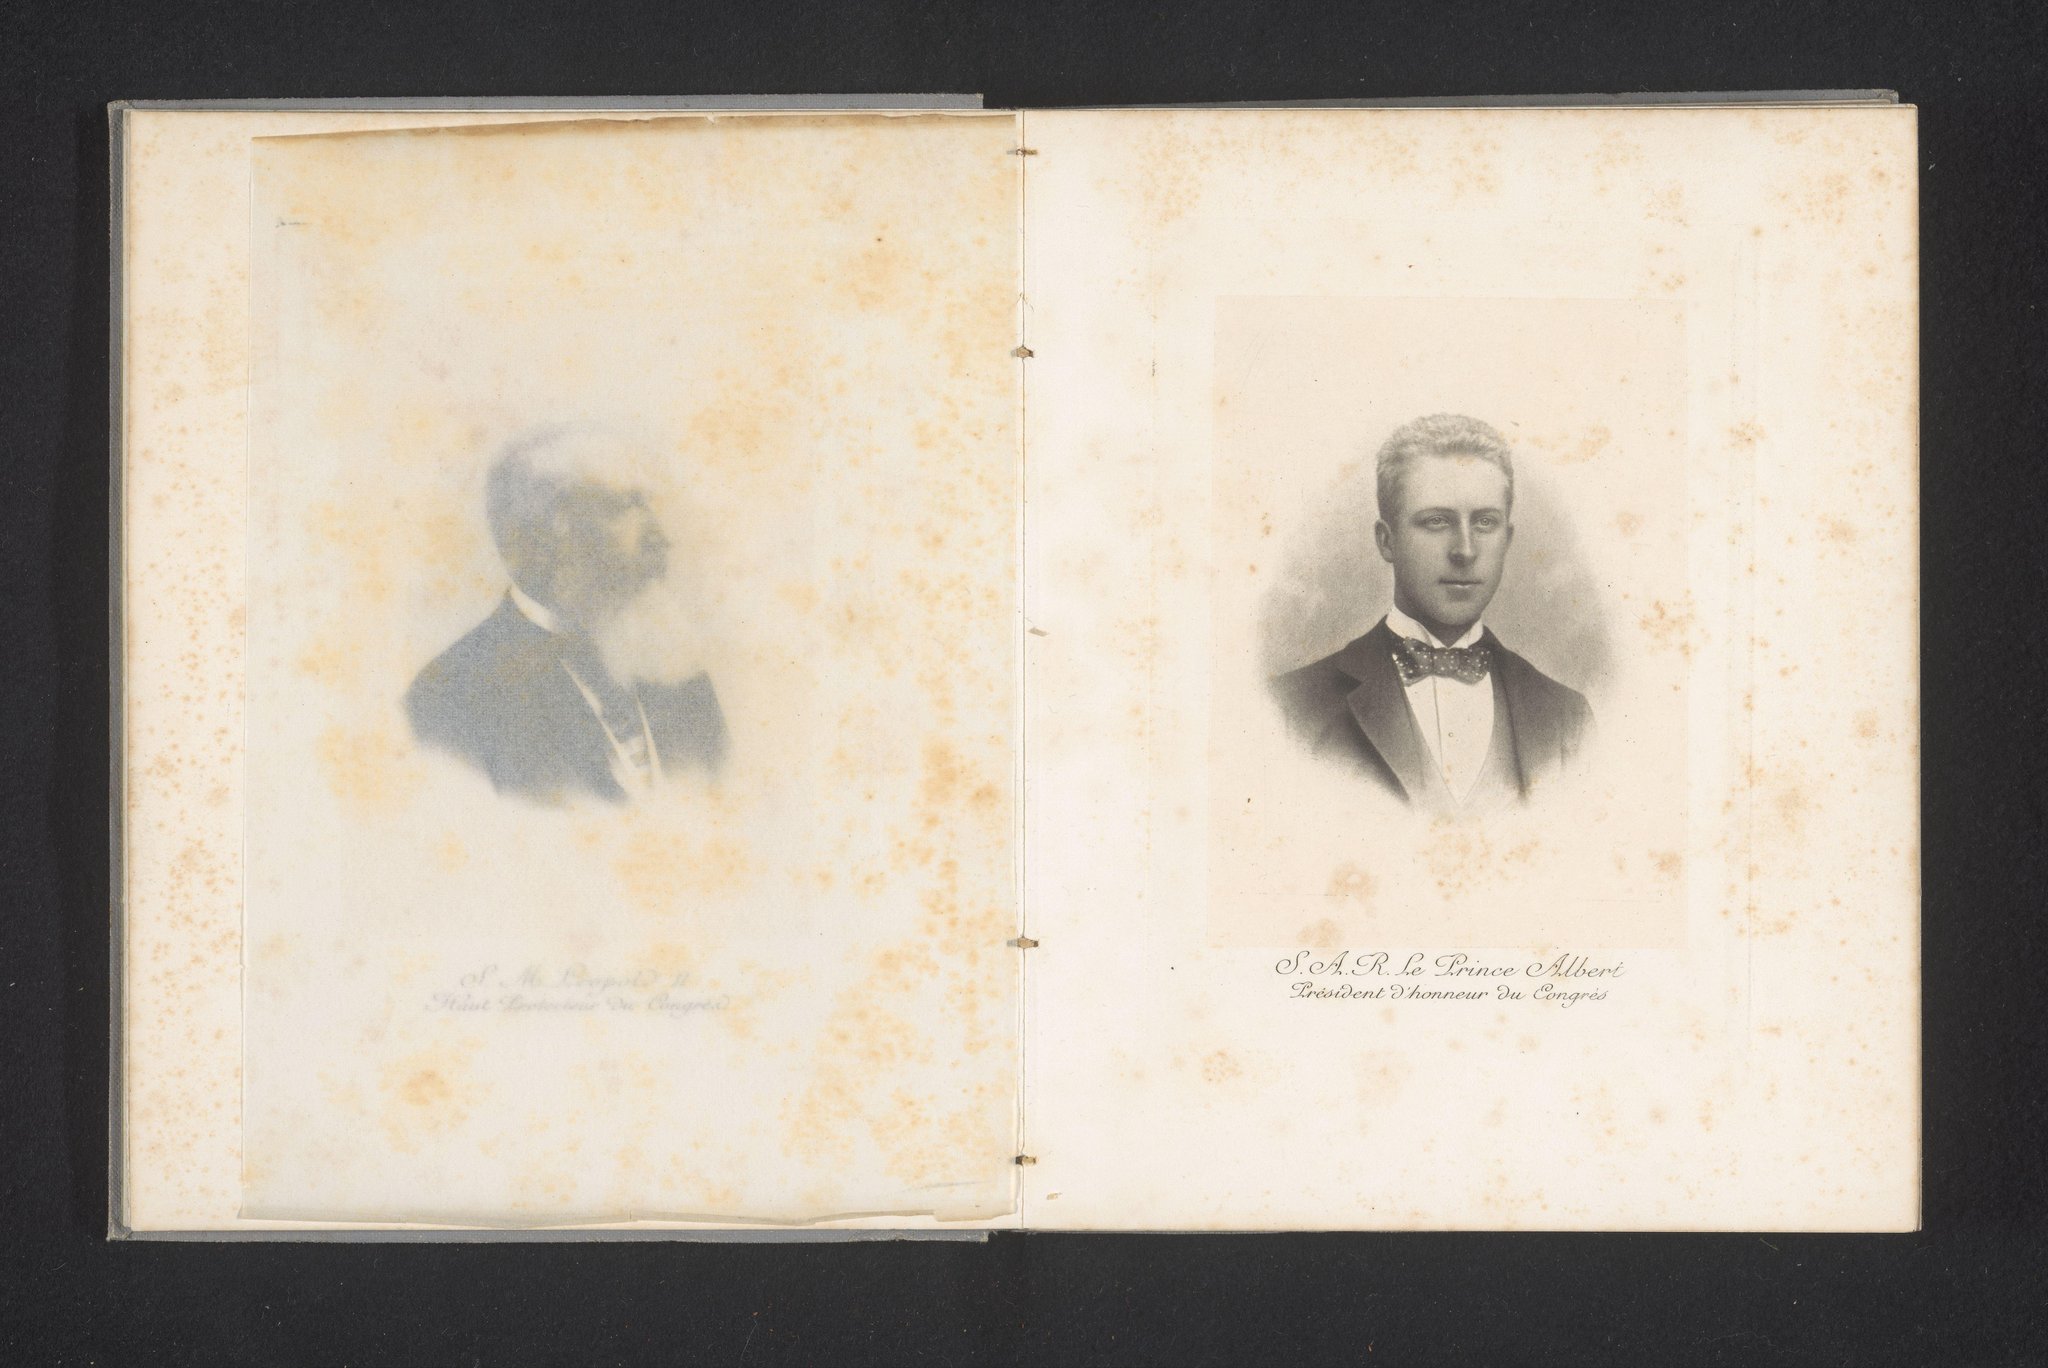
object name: photomechanical print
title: Portret van Albert I van België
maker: Anonymous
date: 1893-1898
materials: paper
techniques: photoaquatint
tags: historical persons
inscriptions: inscription: ‘President l'honneur du Congres’